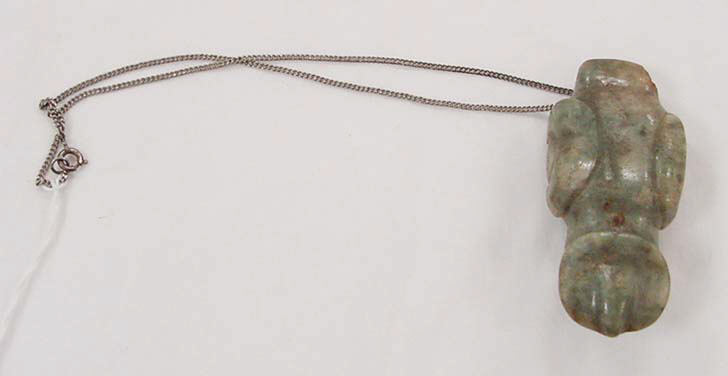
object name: necklace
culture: indigenous american, olmec peoples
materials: jade, metal